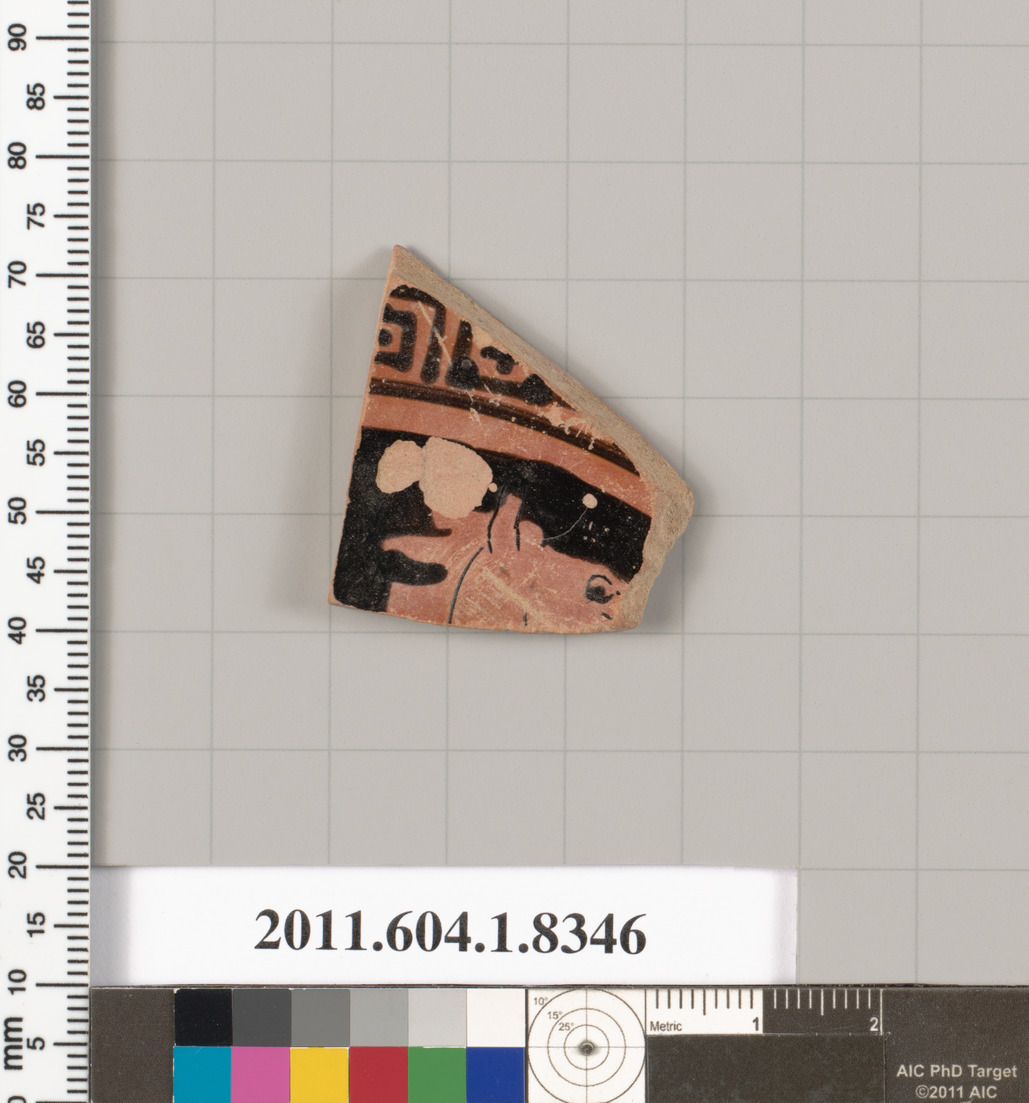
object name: kylix fragment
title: Terracotta fragment of a kylix (drinking cup)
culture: greek, attic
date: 450-426 BCE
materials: terracotta